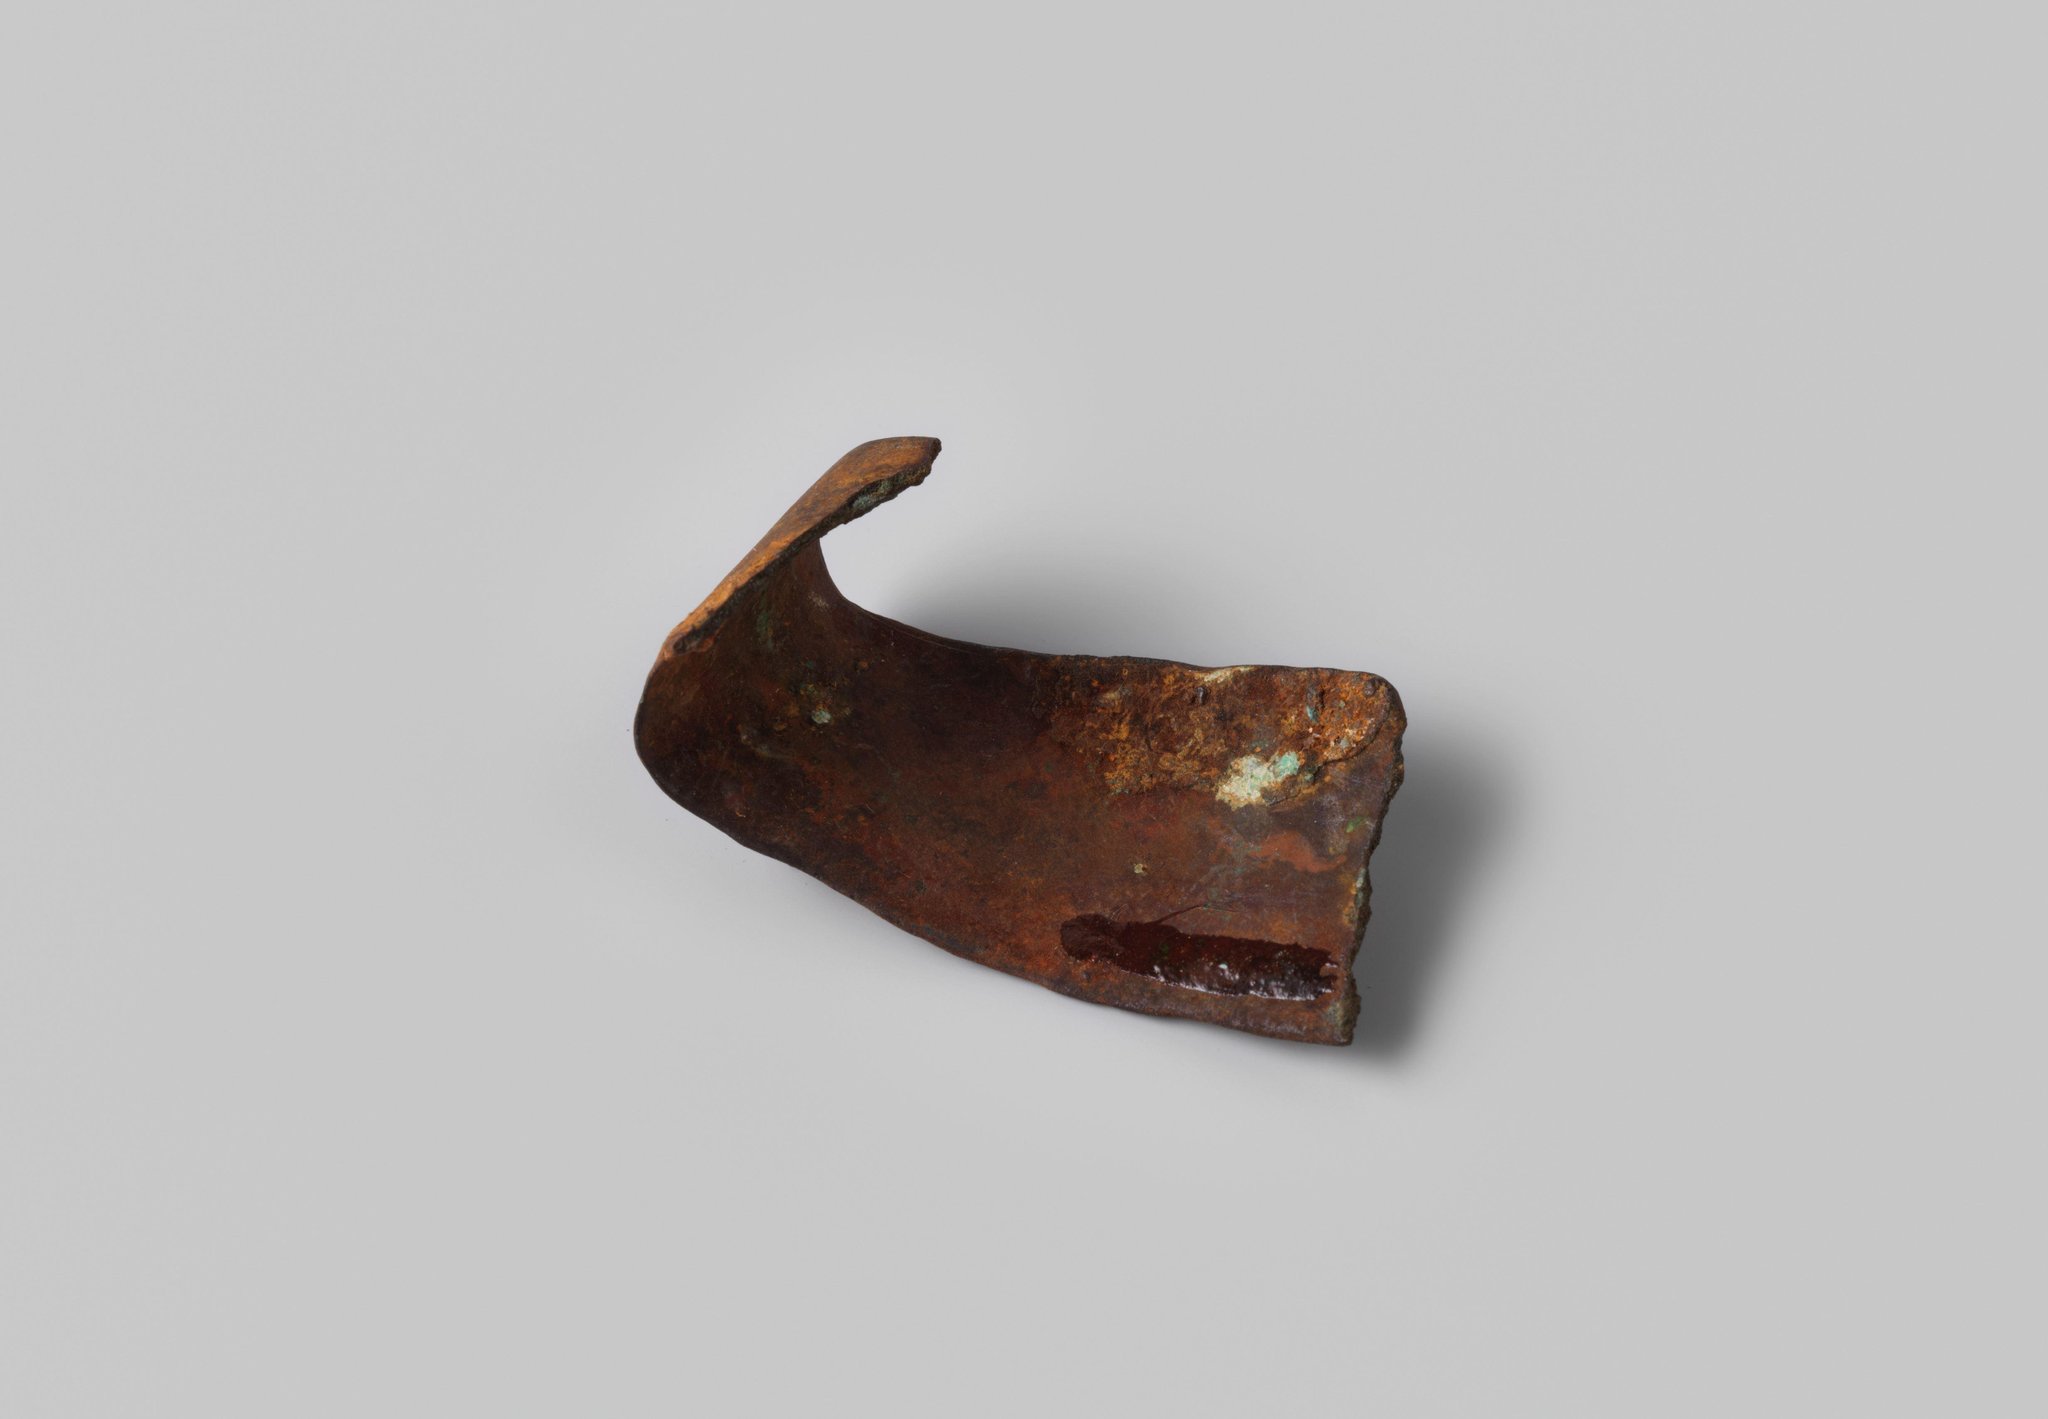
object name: fragment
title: Fragment van koper uit het wrak van de Oost-Indiëvaarder Hollandia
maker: Anonymous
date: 1700-1743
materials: copper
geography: netherlands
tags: verenigde oostindische compagnie, hollandia (schip), annet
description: Varied parts or fragments, strips and strip-shaped fragments; fragm.